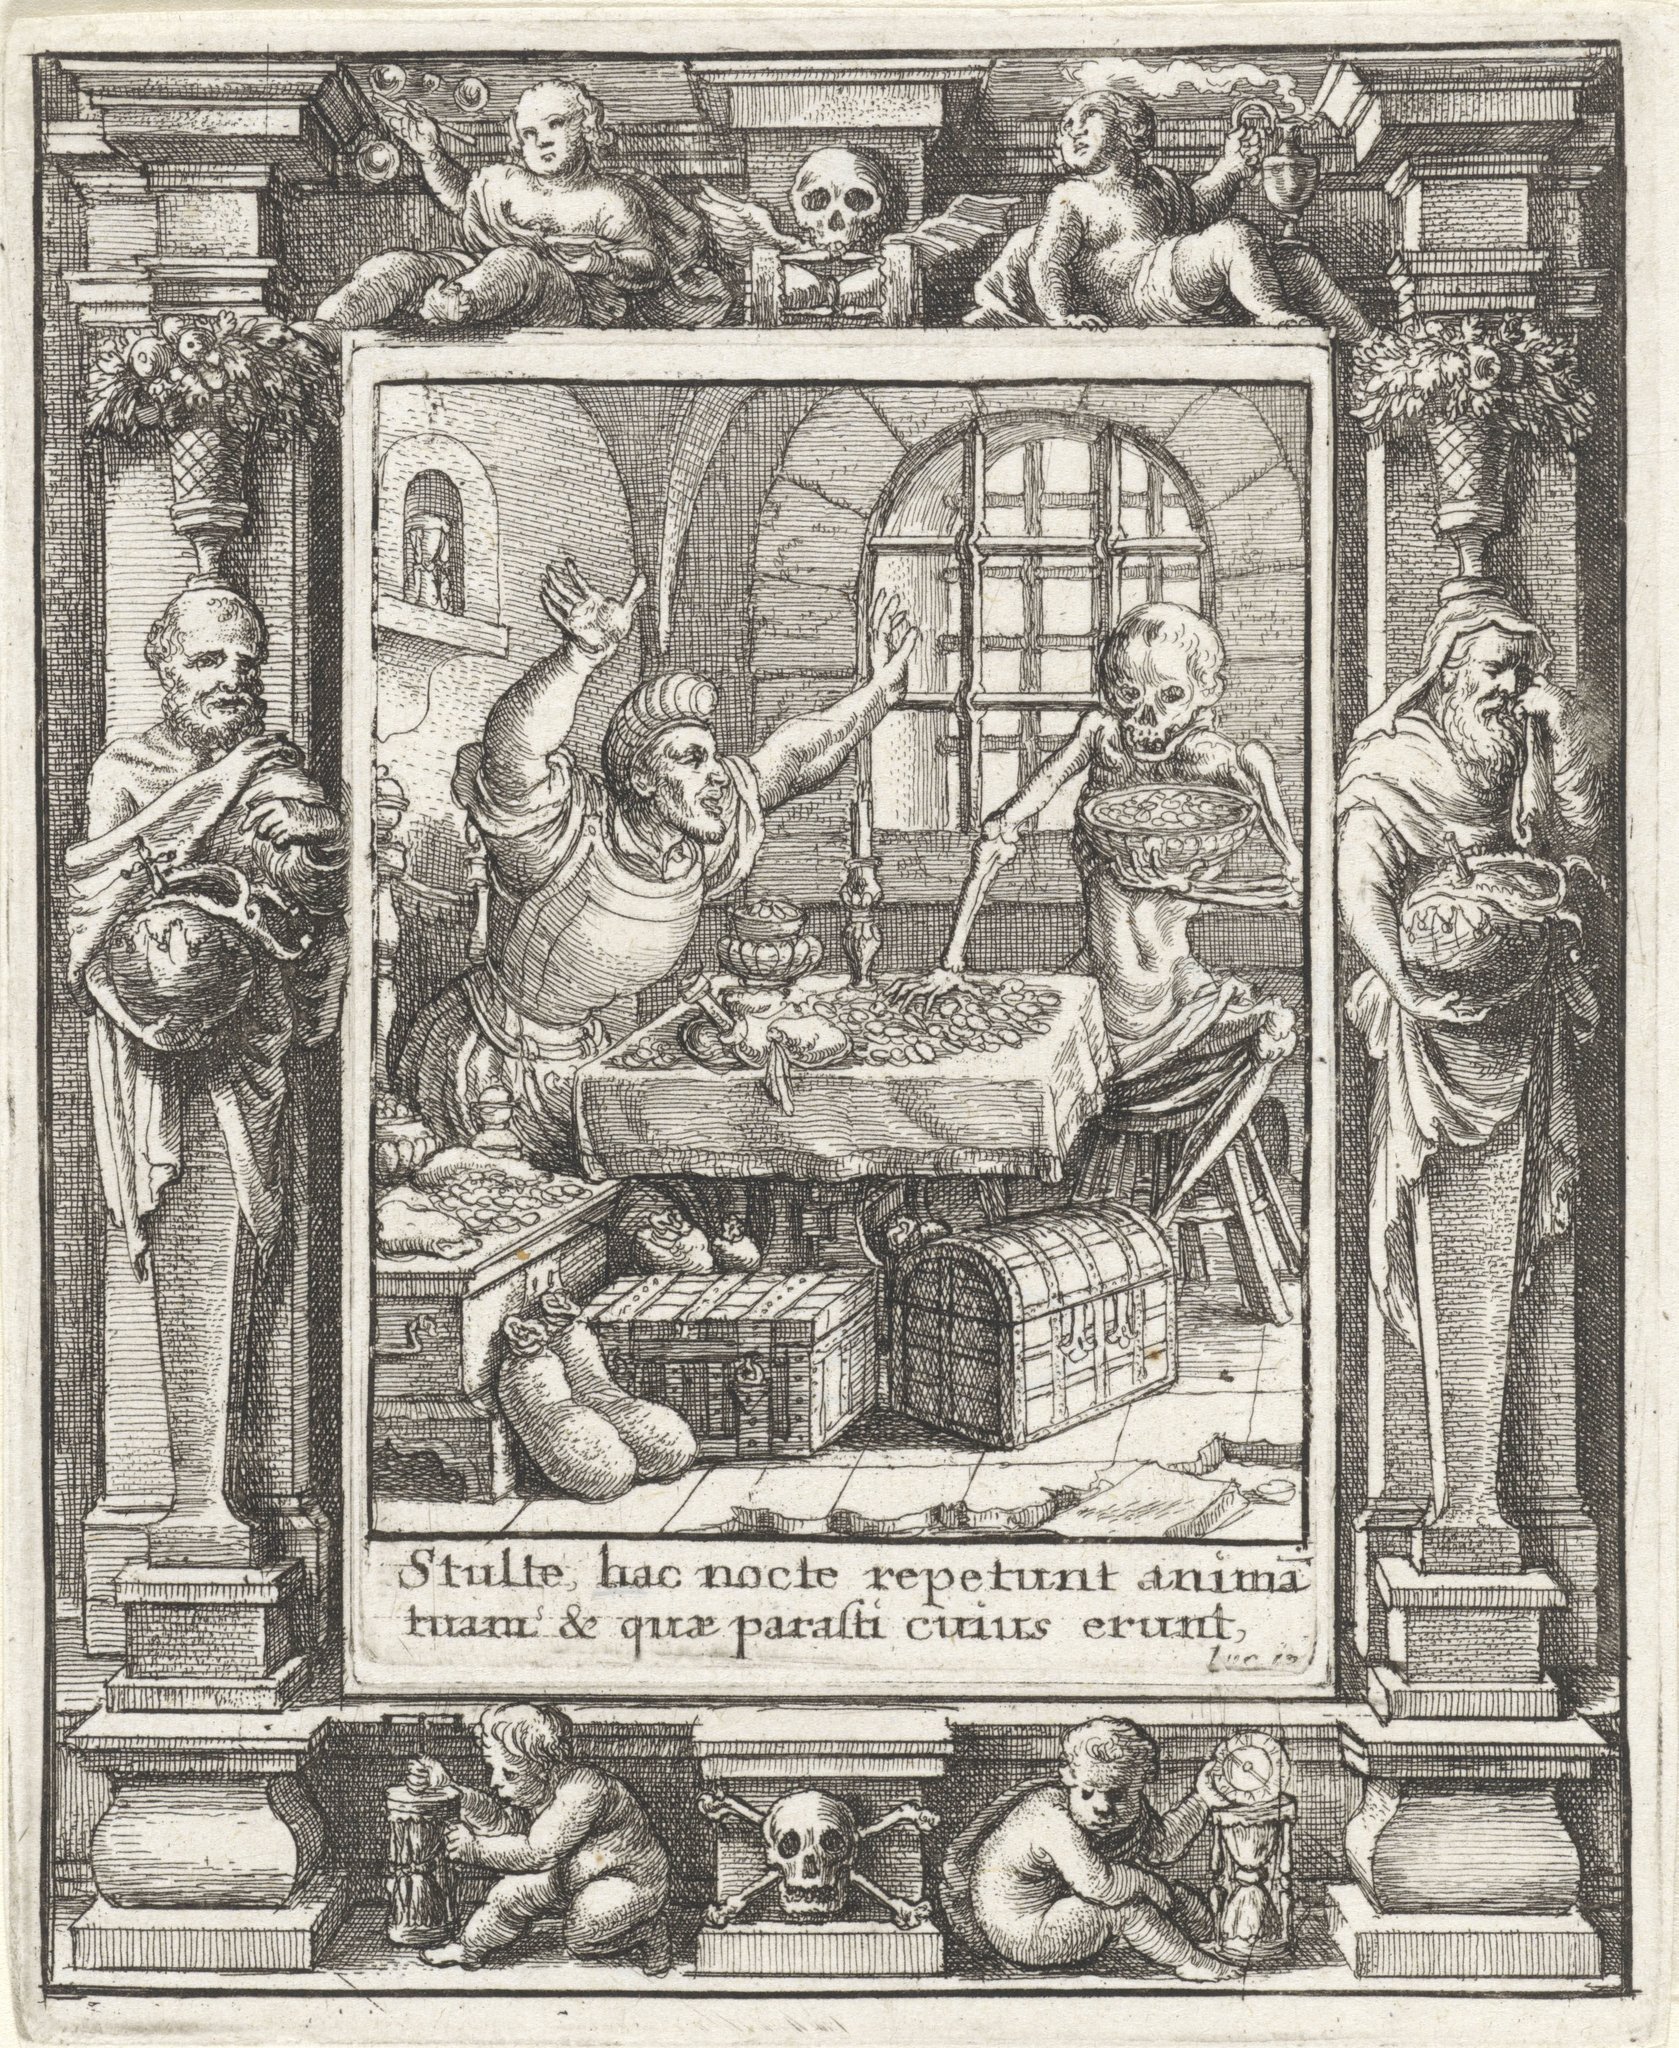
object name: print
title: De rijke man en de Dood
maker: wenceslaus hollar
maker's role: draughtsman, print maker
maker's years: 1607-1677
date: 1651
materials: paper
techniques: etching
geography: antwerp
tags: dance of death; death together with one or more human beings, (story of) heraclitus, the philosopher, (story of) democritus, the philosopher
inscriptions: collector's mark: Lugt 2228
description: Een rijke man zit aan tafel omringd door kisten en zakken met geld. De Dood pakt munten van tafel en doet ze in een schaal. 25ste prent uit een reeks van 30 dodendansprenten; met een omlijsting met Democritus en Heraclitus.